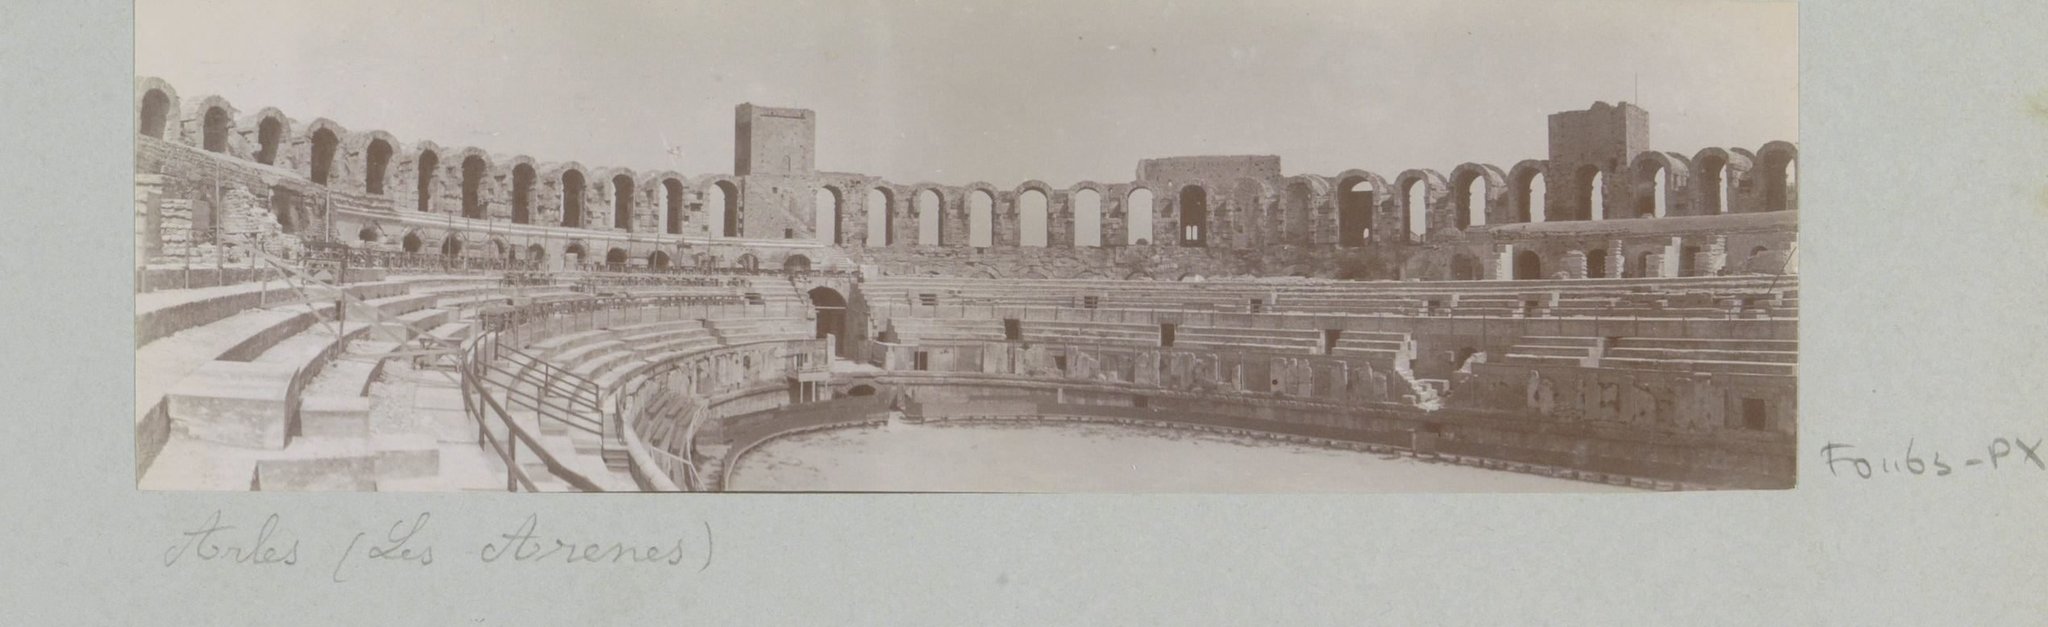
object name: panoramic photograph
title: Interieur van de Arena van Arles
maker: delizy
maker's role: manufacturer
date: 1903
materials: paper, photographic support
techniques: gelatin silver print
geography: arena van arles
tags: grounds, fields and accomodations for sports, games and physical performances (+ out of doors (sports, games, etc.))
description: Onderdeel van Fotoalbum van een Franse amateurfotograaf met opnames van uitstapjes in Frankrijk, Spanje, België, Luxemburg en Nederland, de eerste automobielen en autoraces.